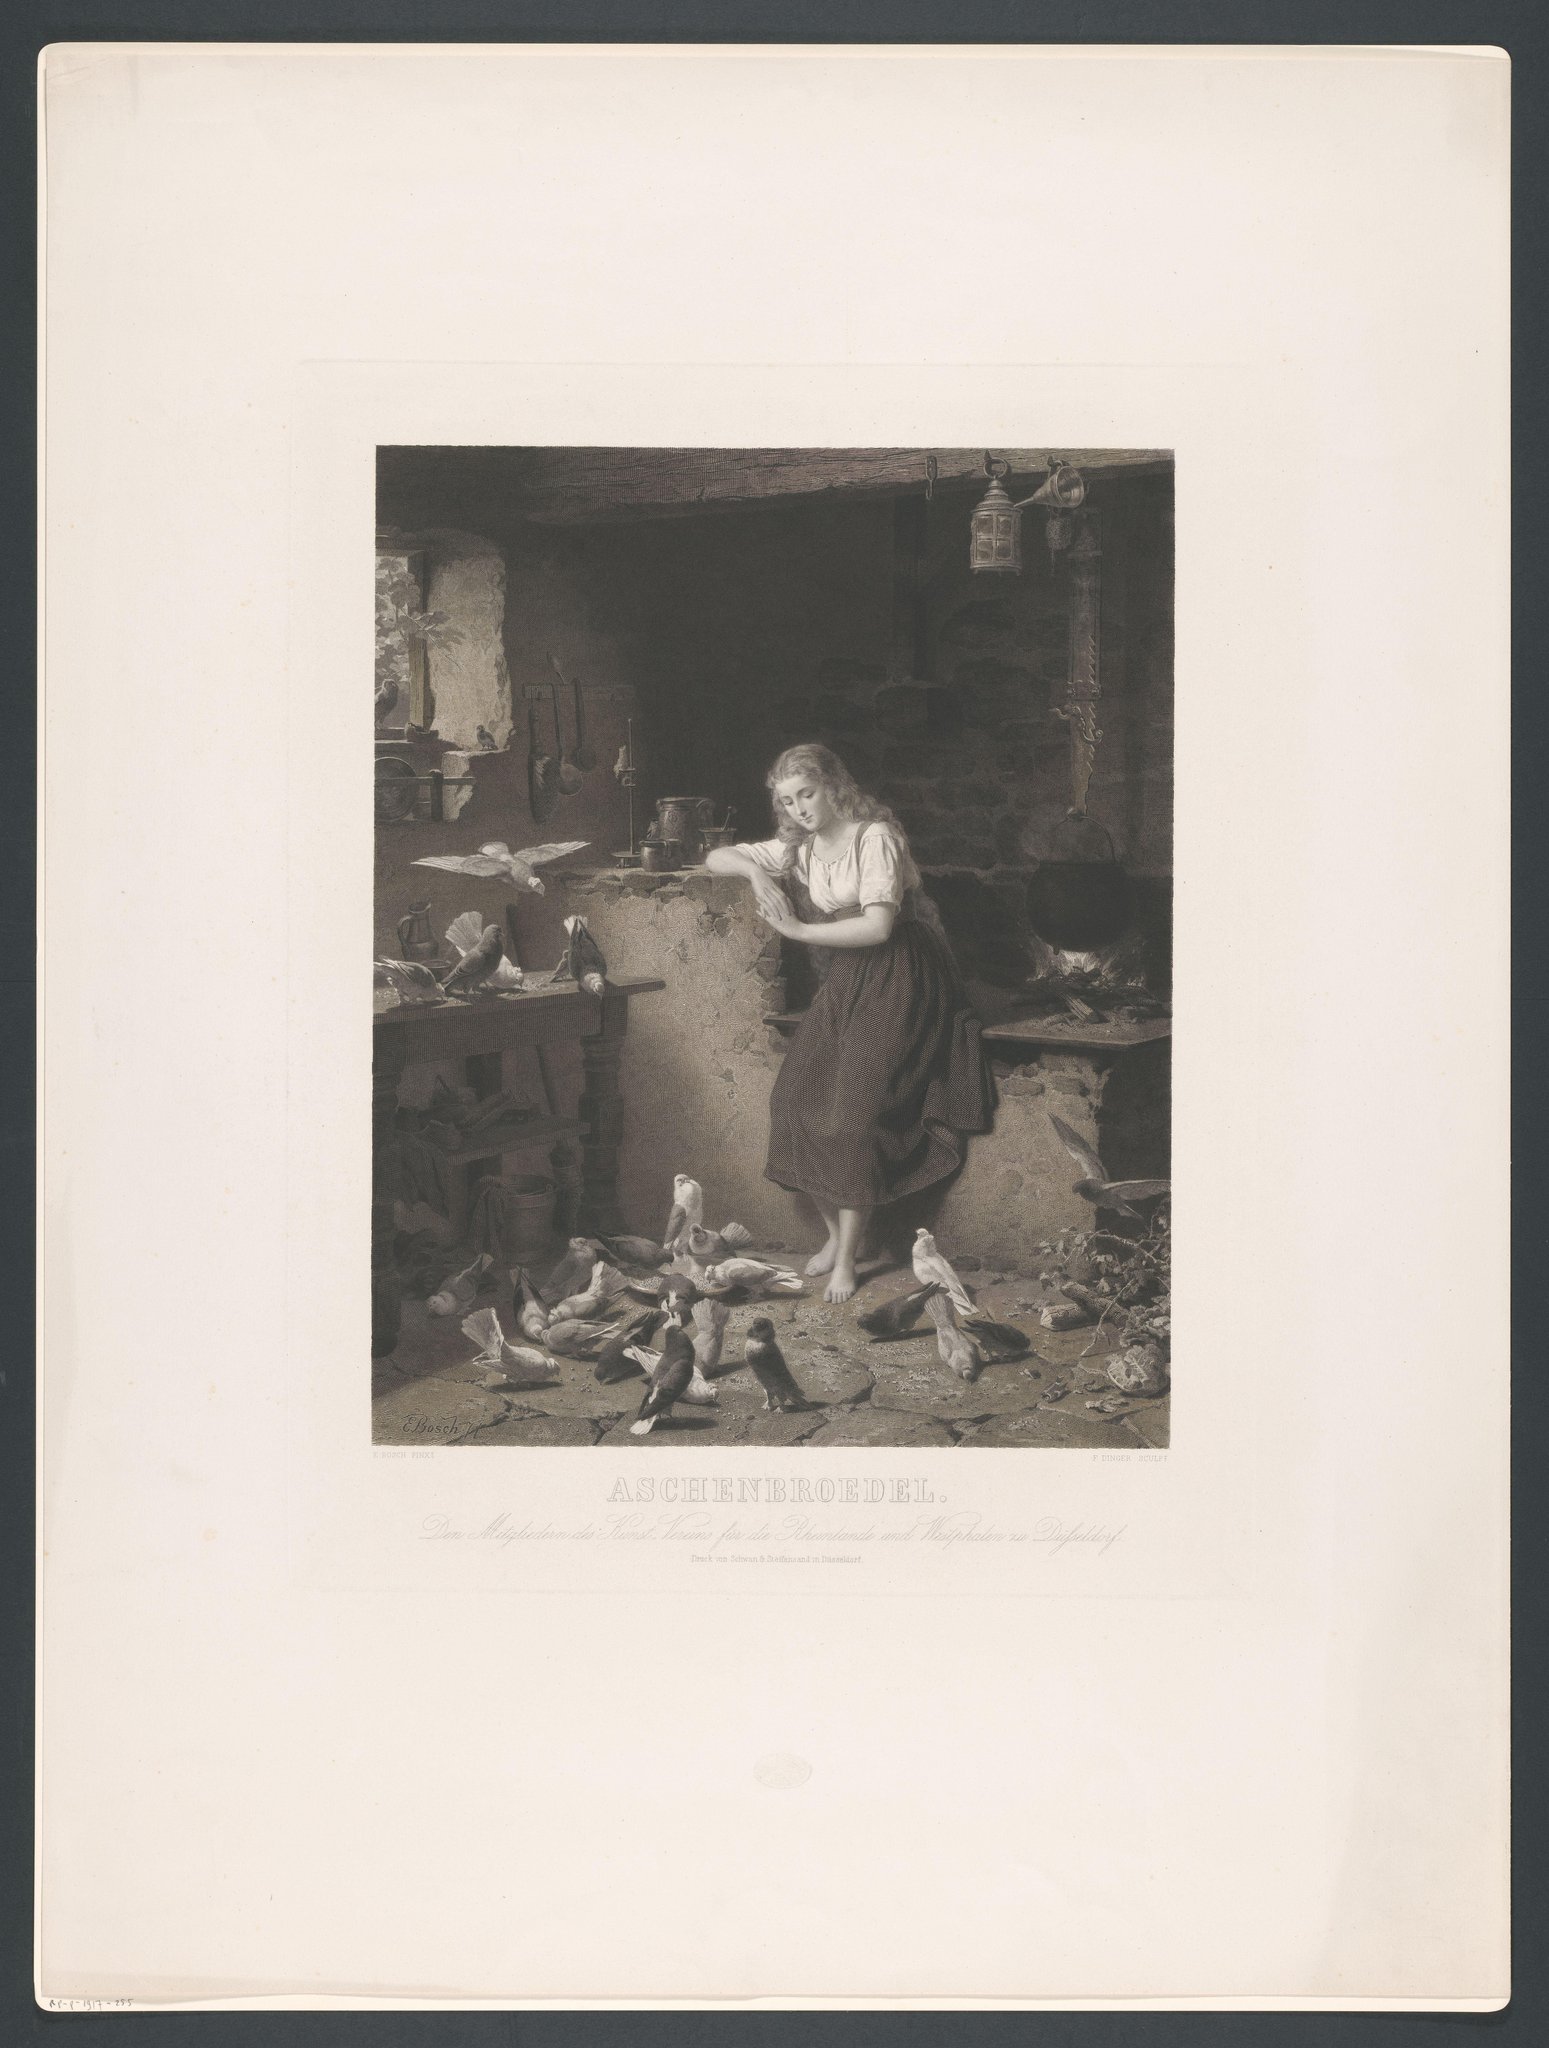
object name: print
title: Aschenbroedel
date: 1900-1904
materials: paper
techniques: engraving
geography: dusseldorf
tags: the ballet, ballet performance, specific works of literature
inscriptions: collector's mark: Lugt 2228